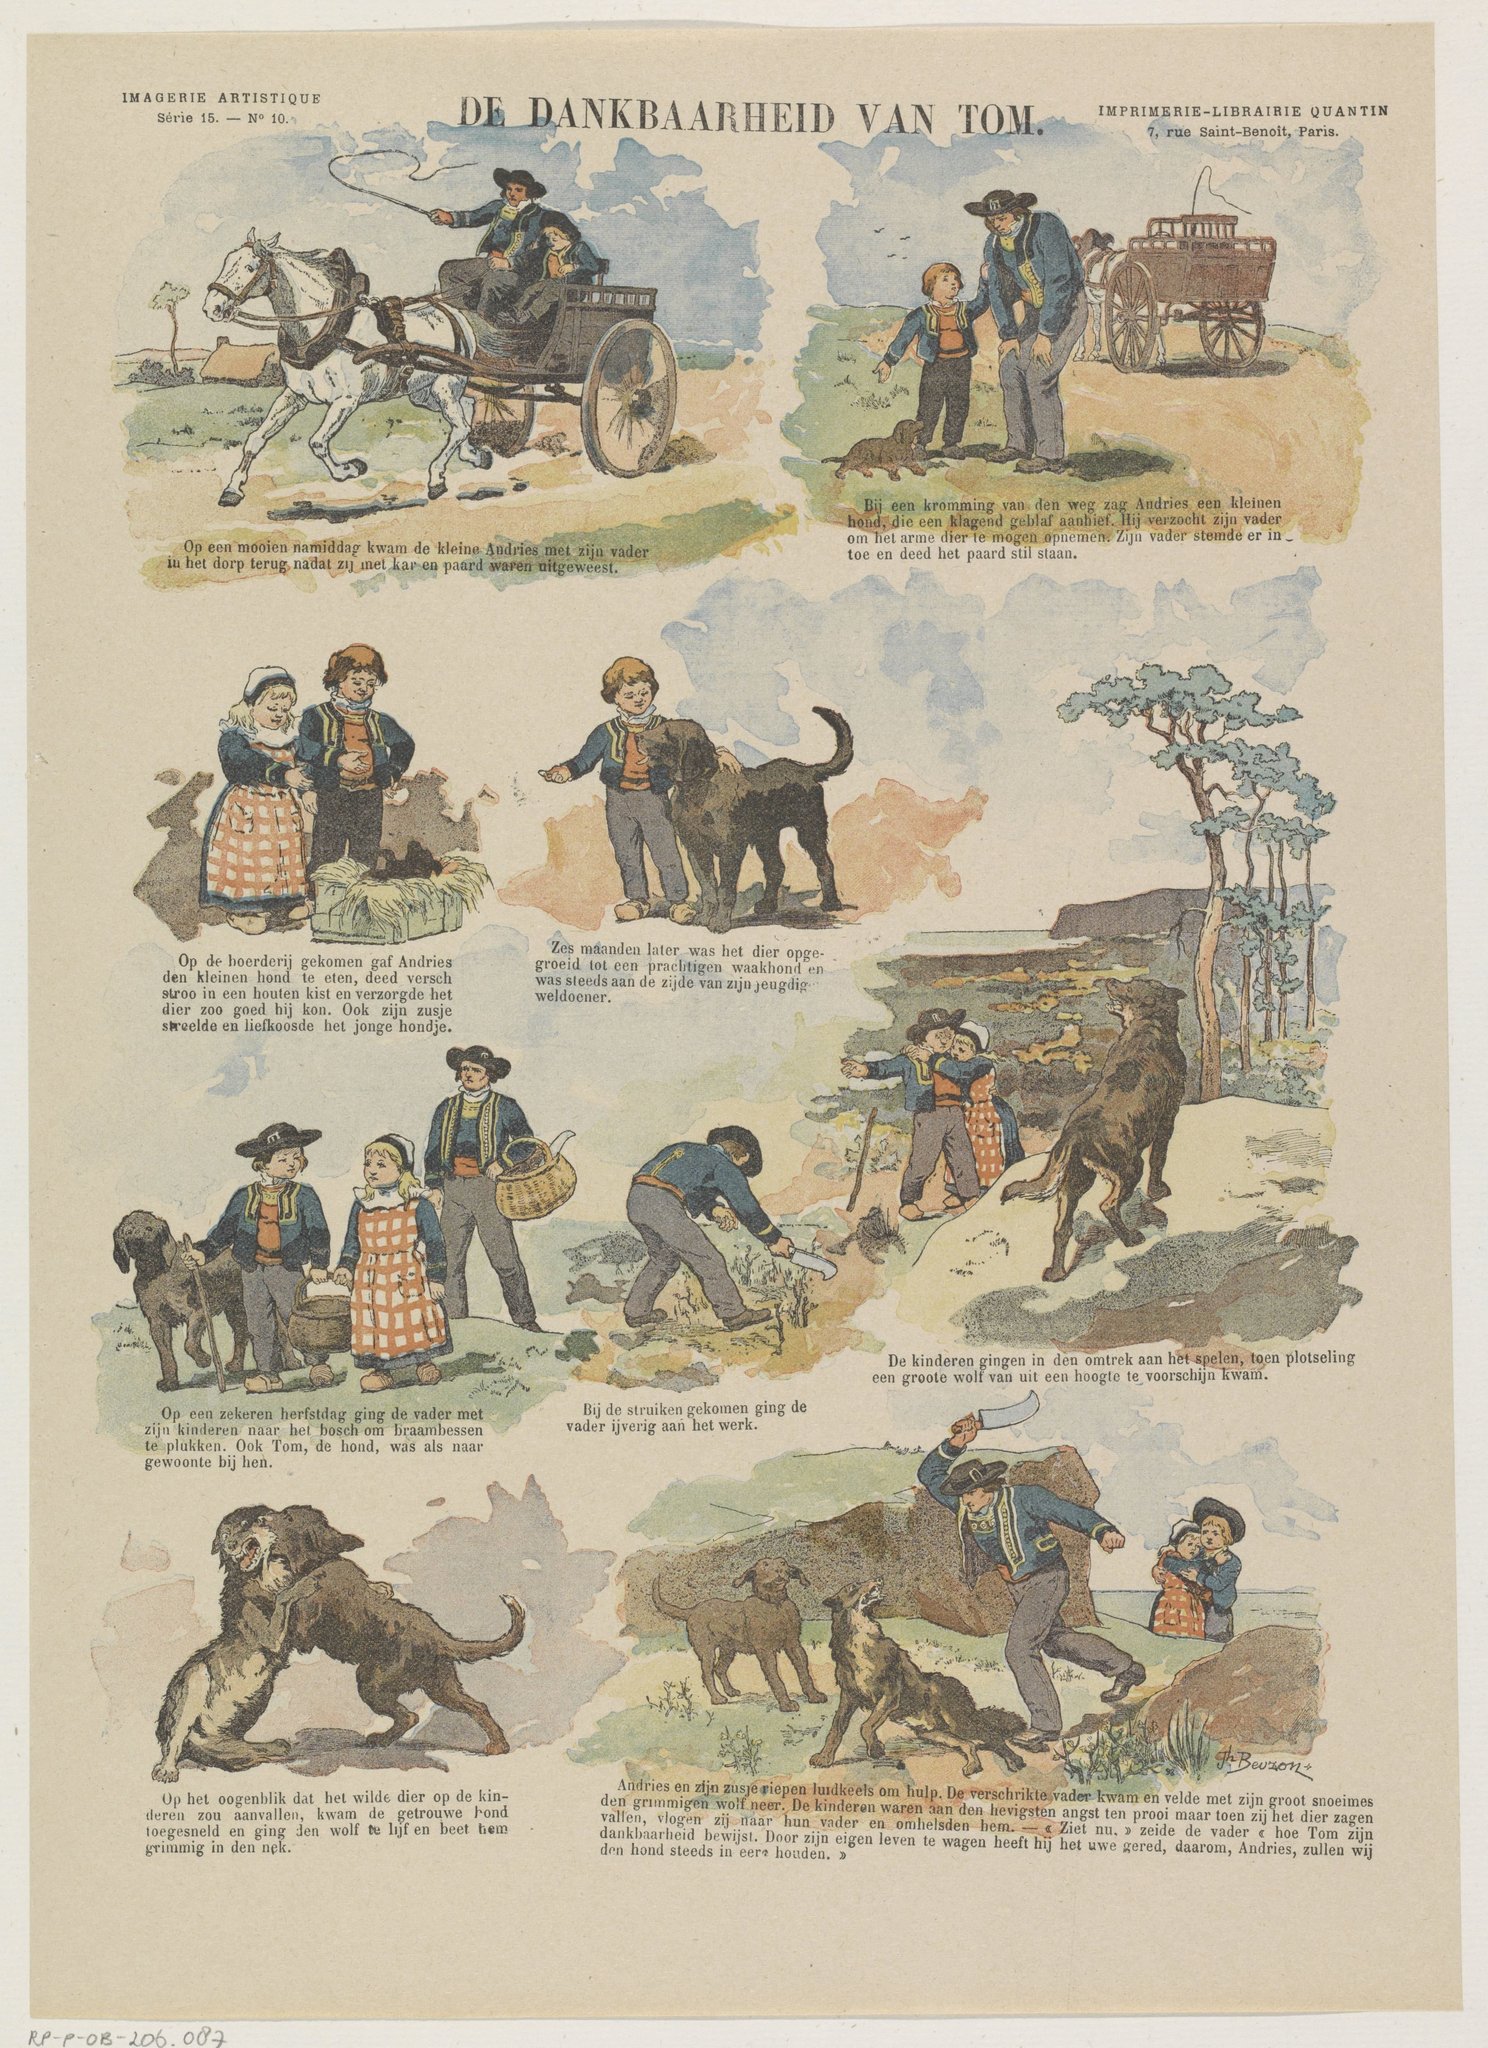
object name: popular print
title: Imagerie Artistique / Série 15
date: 1876-1890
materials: paper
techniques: lithograph, letterpress printing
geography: paris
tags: child, tales and fairy tales, dog, beasts of prey, predatory animals: wolf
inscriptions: collector's mark: Lugt 2760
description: Blad met 9 voorstellingen van Andries die een jonge hond vindt en hem verzorgt. De hond beschermt Andries en zijn zusje tegen een wolf. Onder elke afbeelding een onderschrift. Genummerd linksboven: Série 15. - No. 10.